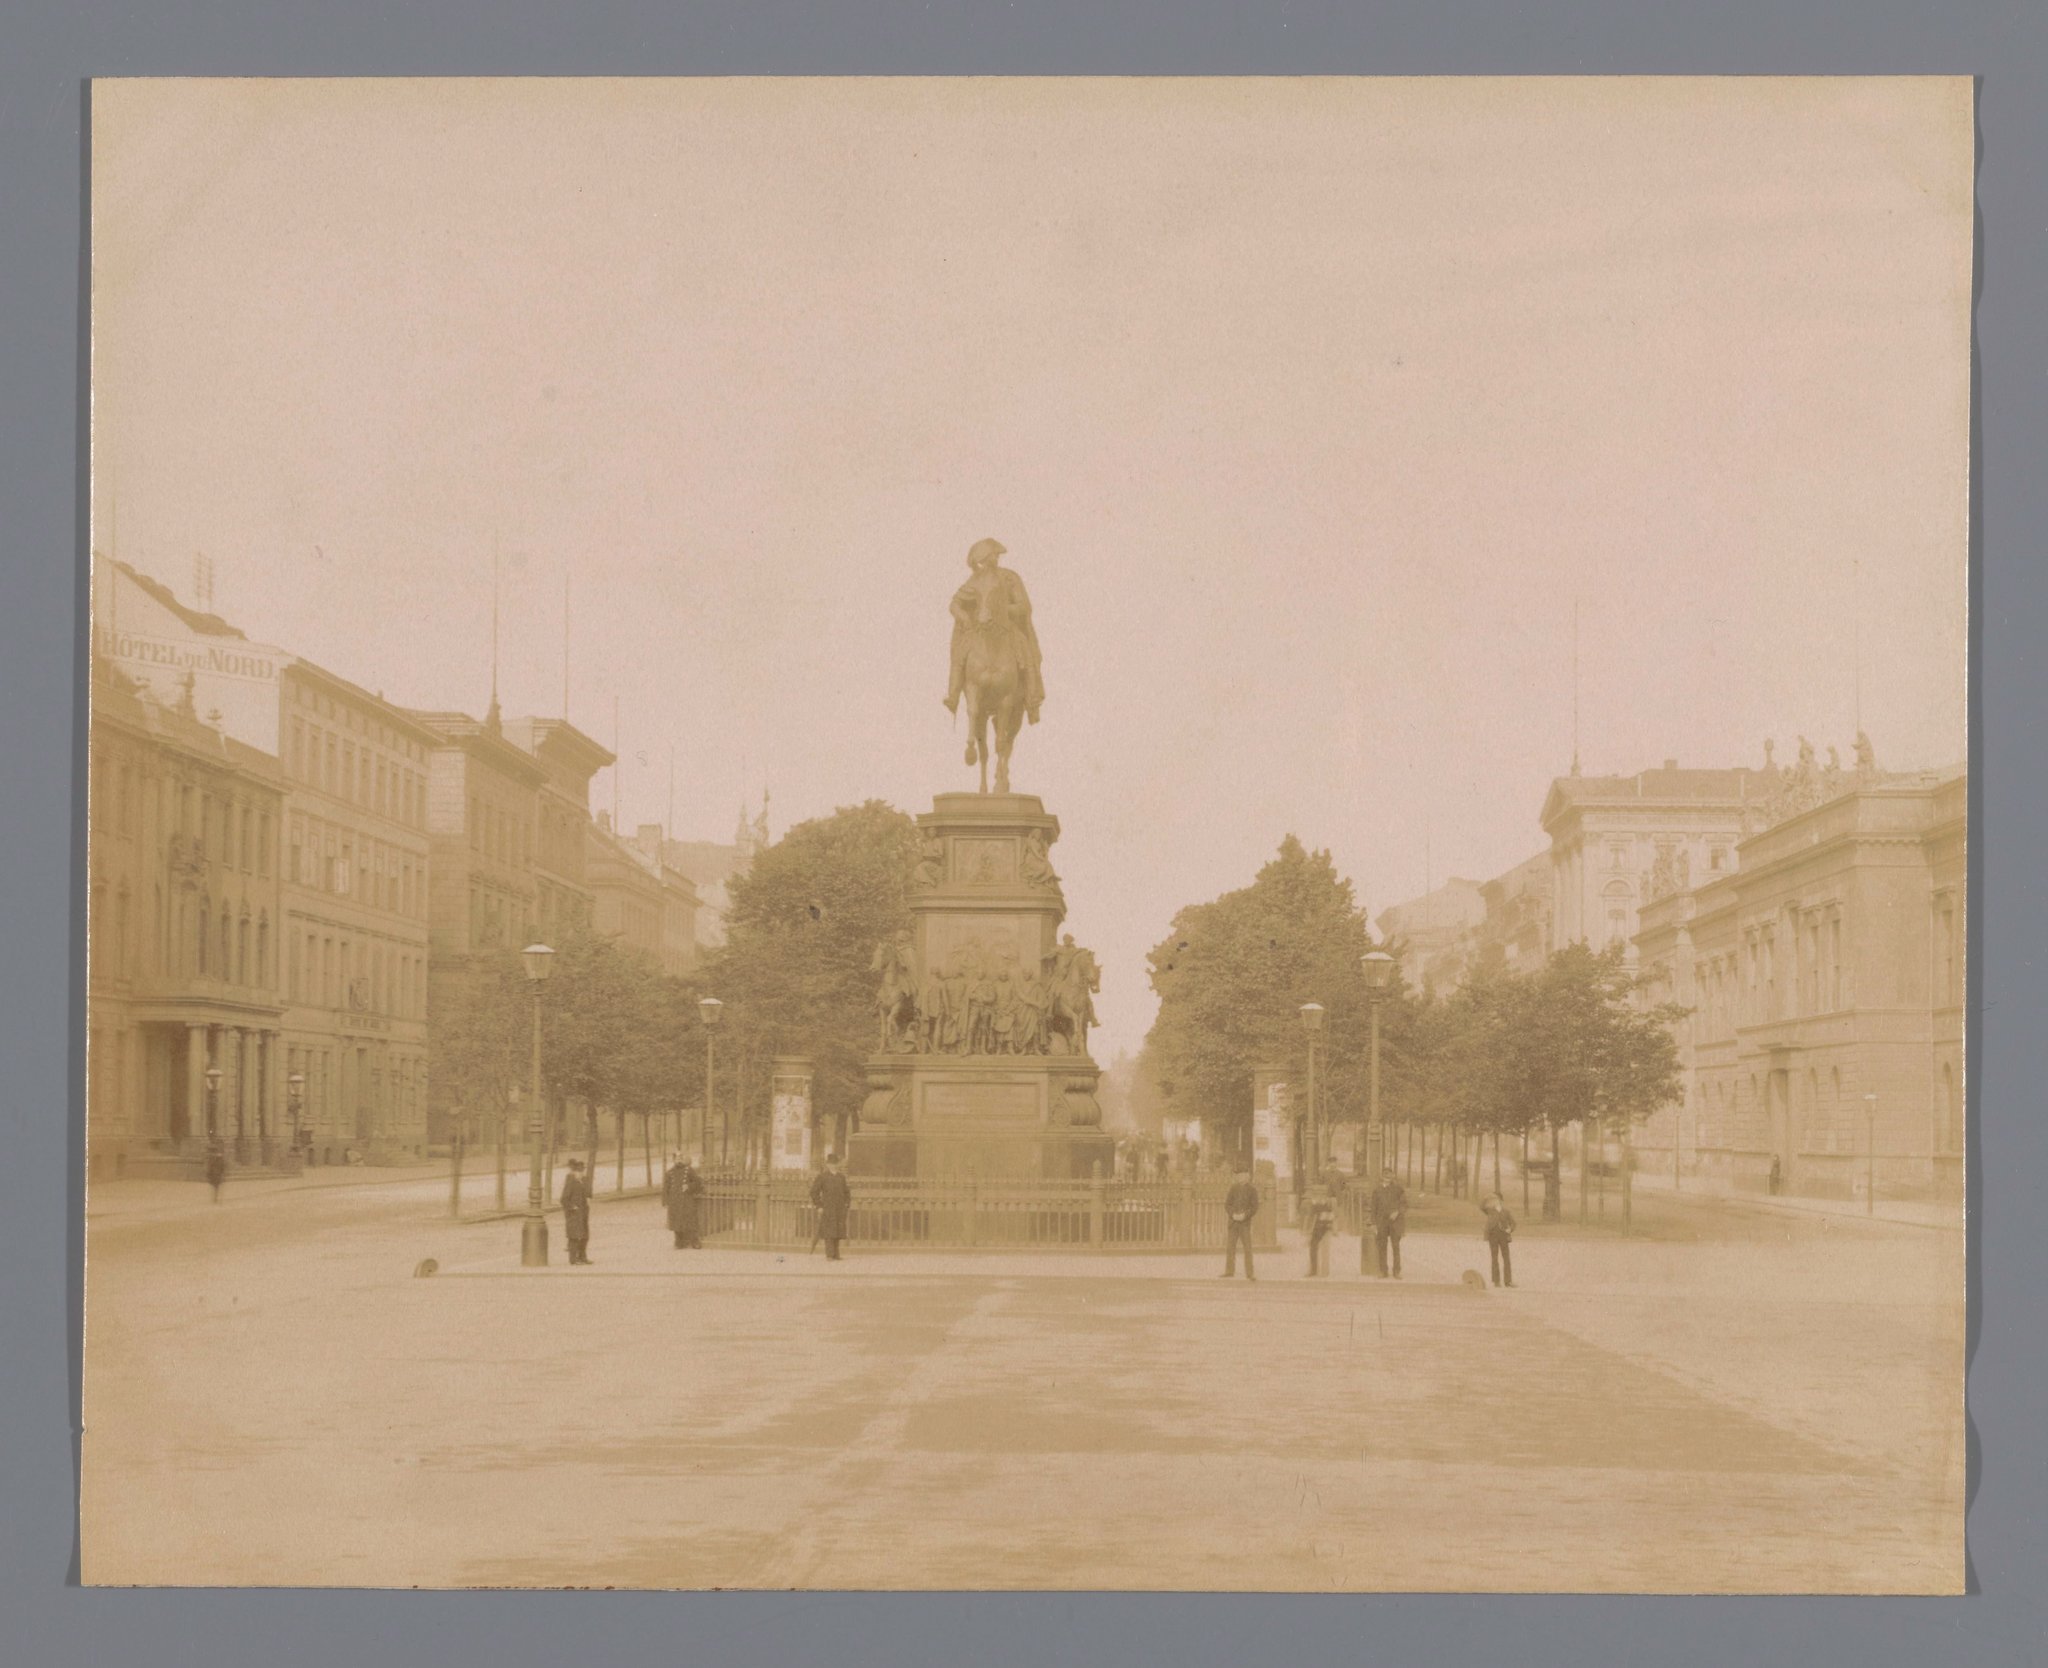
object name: photograph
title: Ruiterstandbeeld van Frederik de Grote aan de Unter den Linden, Berlijn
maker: friedrich albert schwartz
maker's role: fotograaf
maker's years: 1836-1906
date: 1892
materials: paper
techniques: albumen print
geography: berlin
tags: berlin, frederick ii (king of prussia), monument, statue, avenue, boulevard, promenade, esplanade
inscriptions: check stamp: ‘Artist.-Photogr. Gesellschaft/ F. Albert/ Berlin-W.’, inscription: ‘Berlin Unter den Linden’, date: ‘1892’